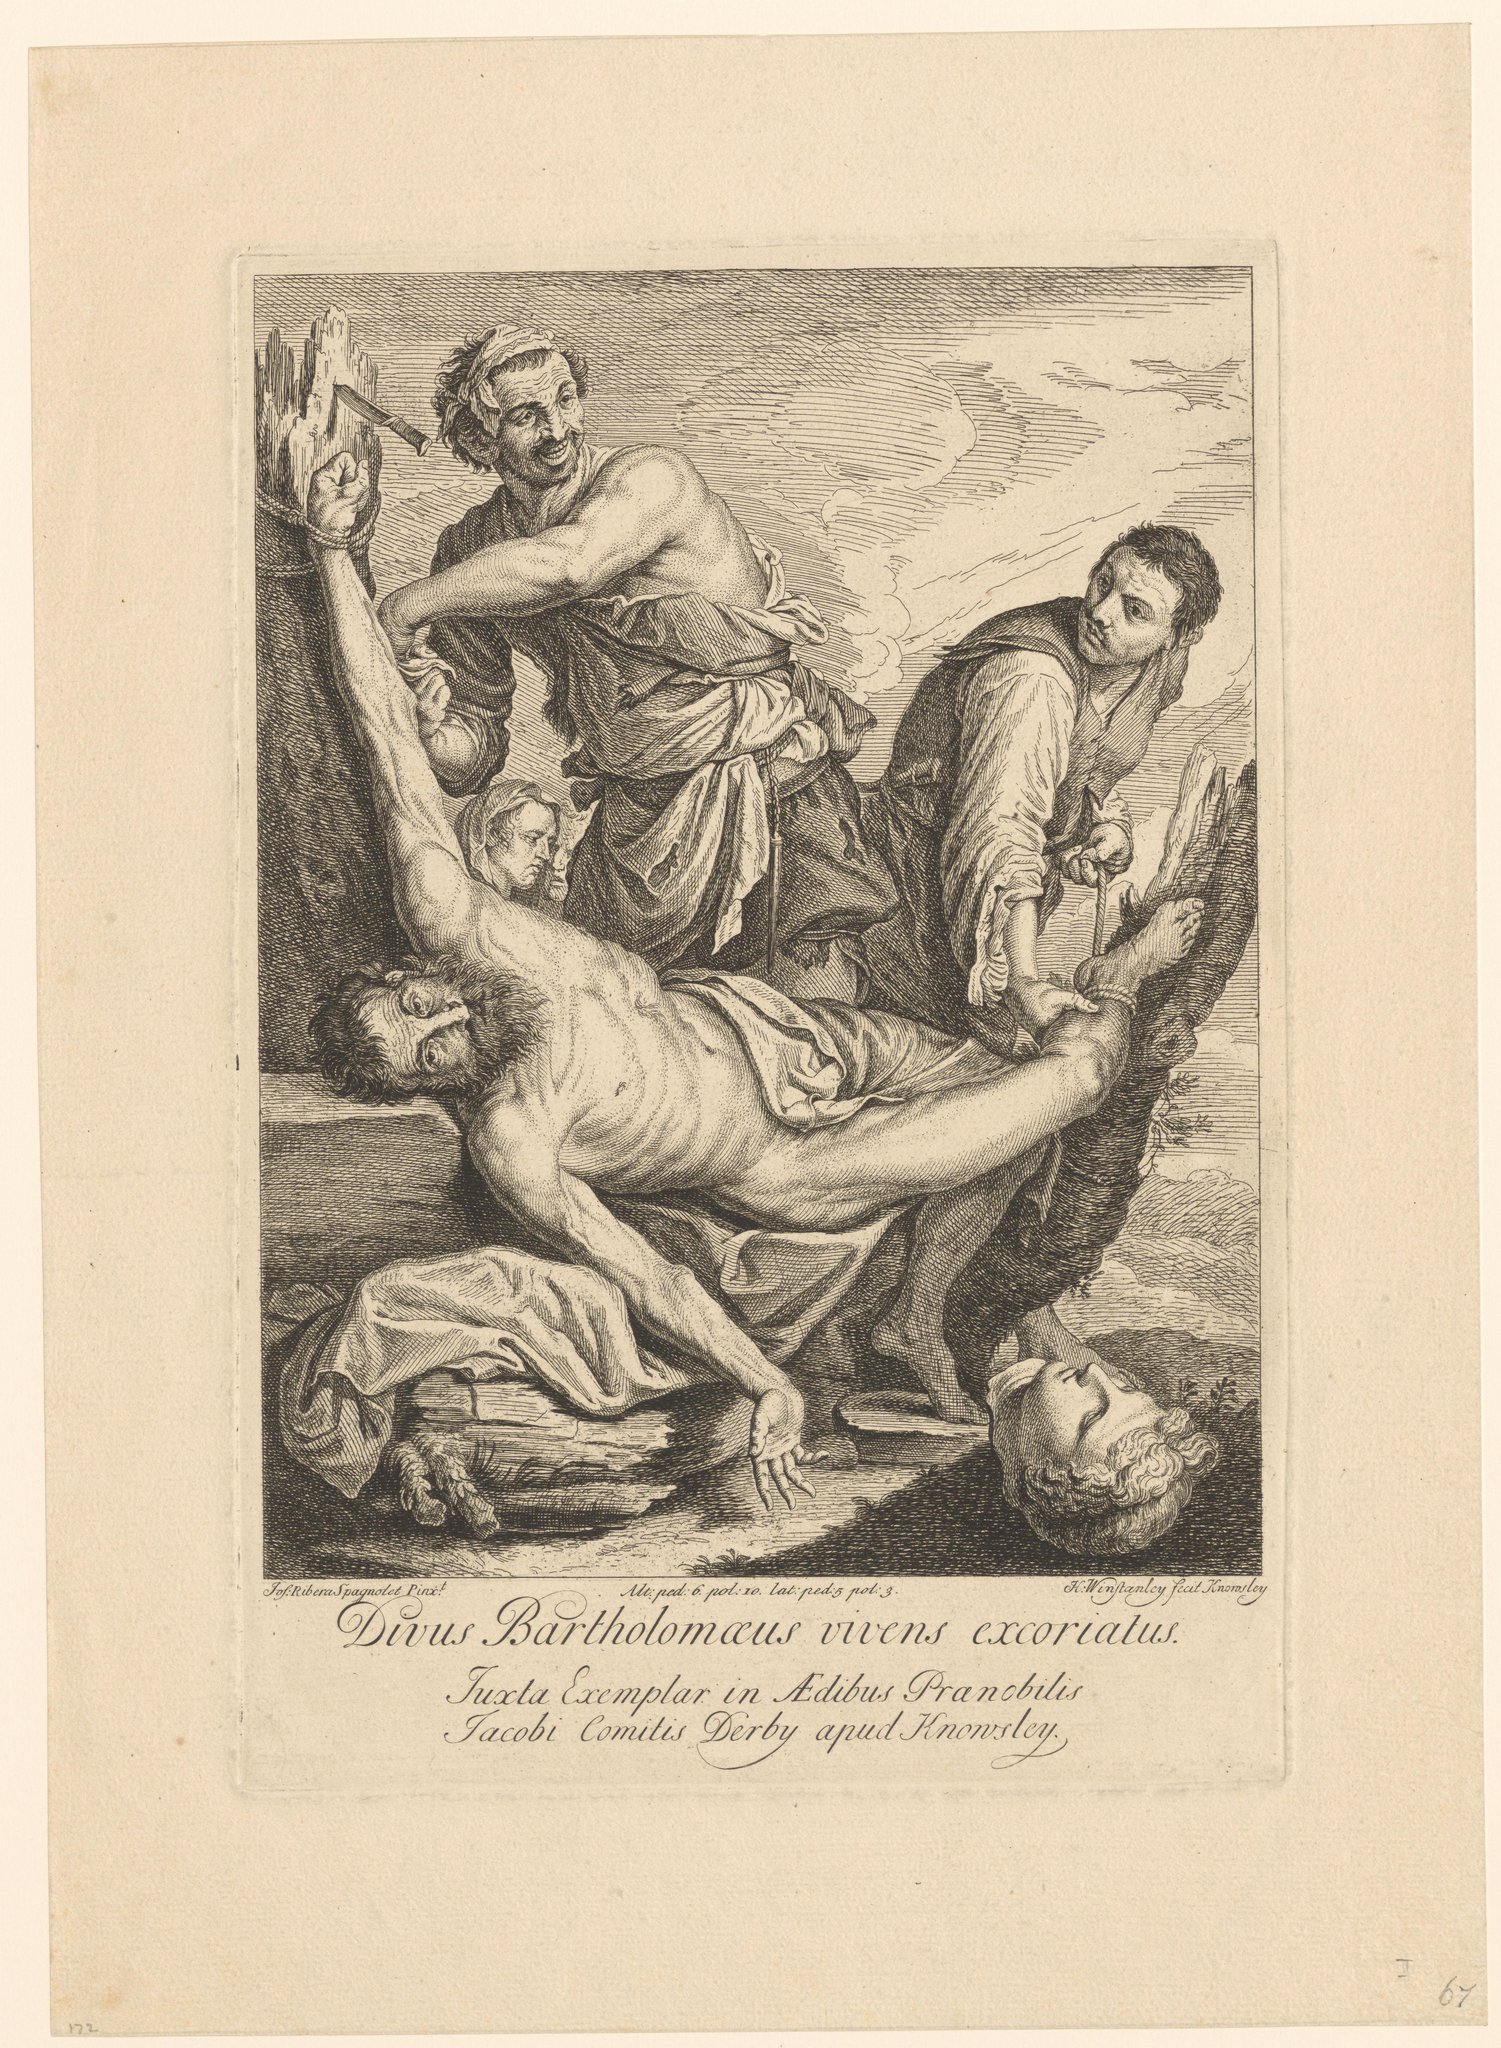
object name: print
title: Schilderijen uit de collectie Knowsley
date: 1728-1729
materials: paper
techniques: etching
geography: knowsley hall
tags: martyrdom and death of bartholomew, the apostle bartholomew; possible attributes: book, devil or dragon at feet, knife, scroll, flayed skin, staff - martyrdom, suffering, misfortune, death of male saint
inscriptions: collector's mark: Lugt 240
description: Bartolomeüs wordt voorafgaand aan zijn marteldood vastgebonden aan twee boomstammen.